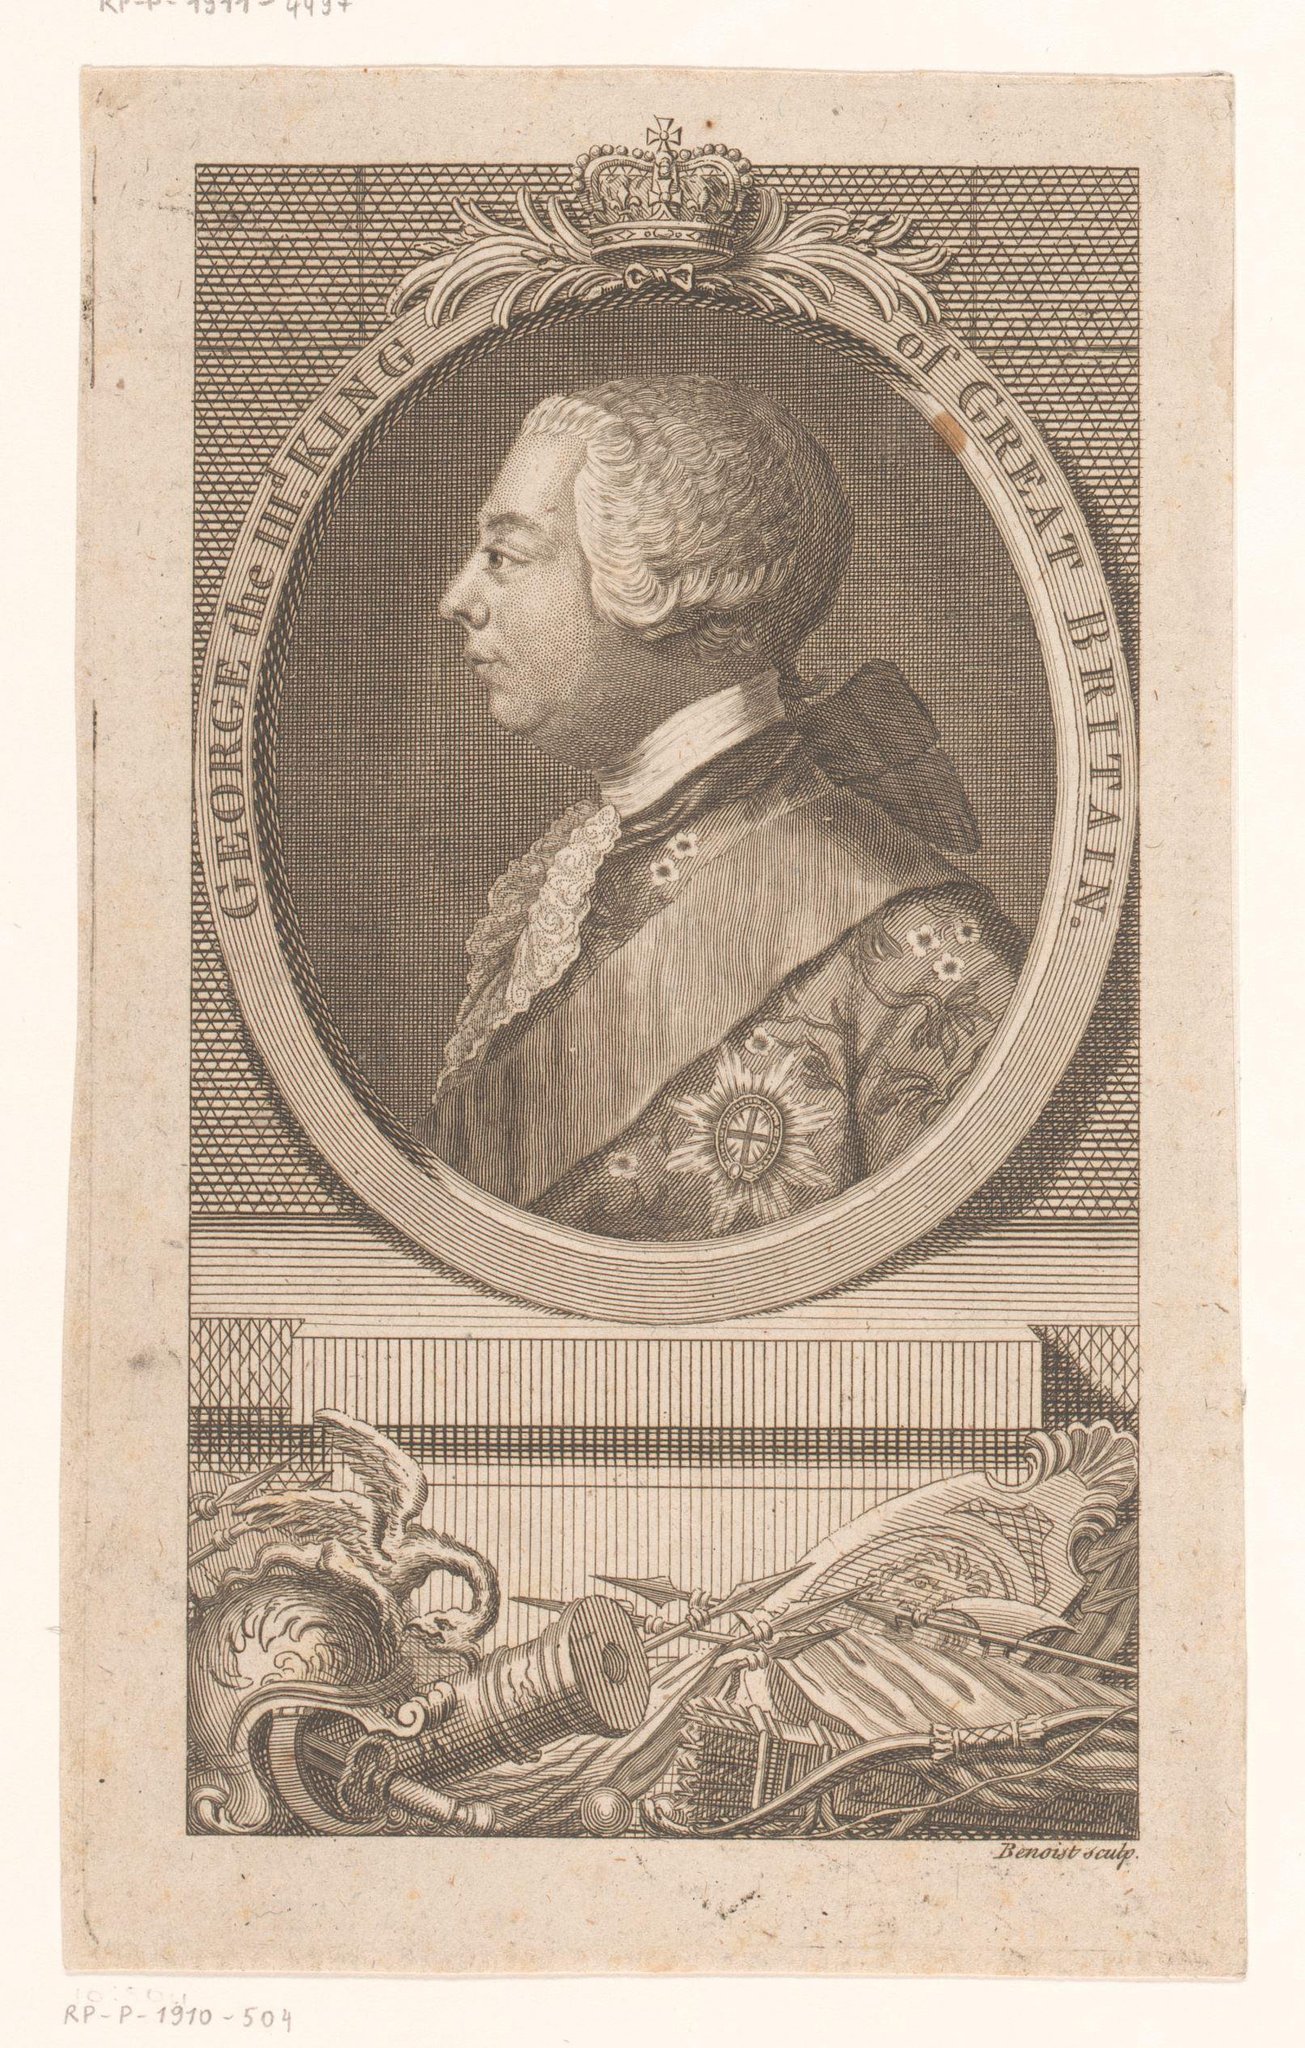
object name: print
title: George the IIId. King of Great Britain.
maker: guillaume philippe benoist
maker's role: print maker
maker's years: 1725-1800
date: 1735-1800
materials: paper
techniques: engraving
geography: france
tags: london, george iii (koning van het verenigd koninkrijk), ornament ~ medallion, historical persons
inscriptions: collector's mark: Lugt 2228